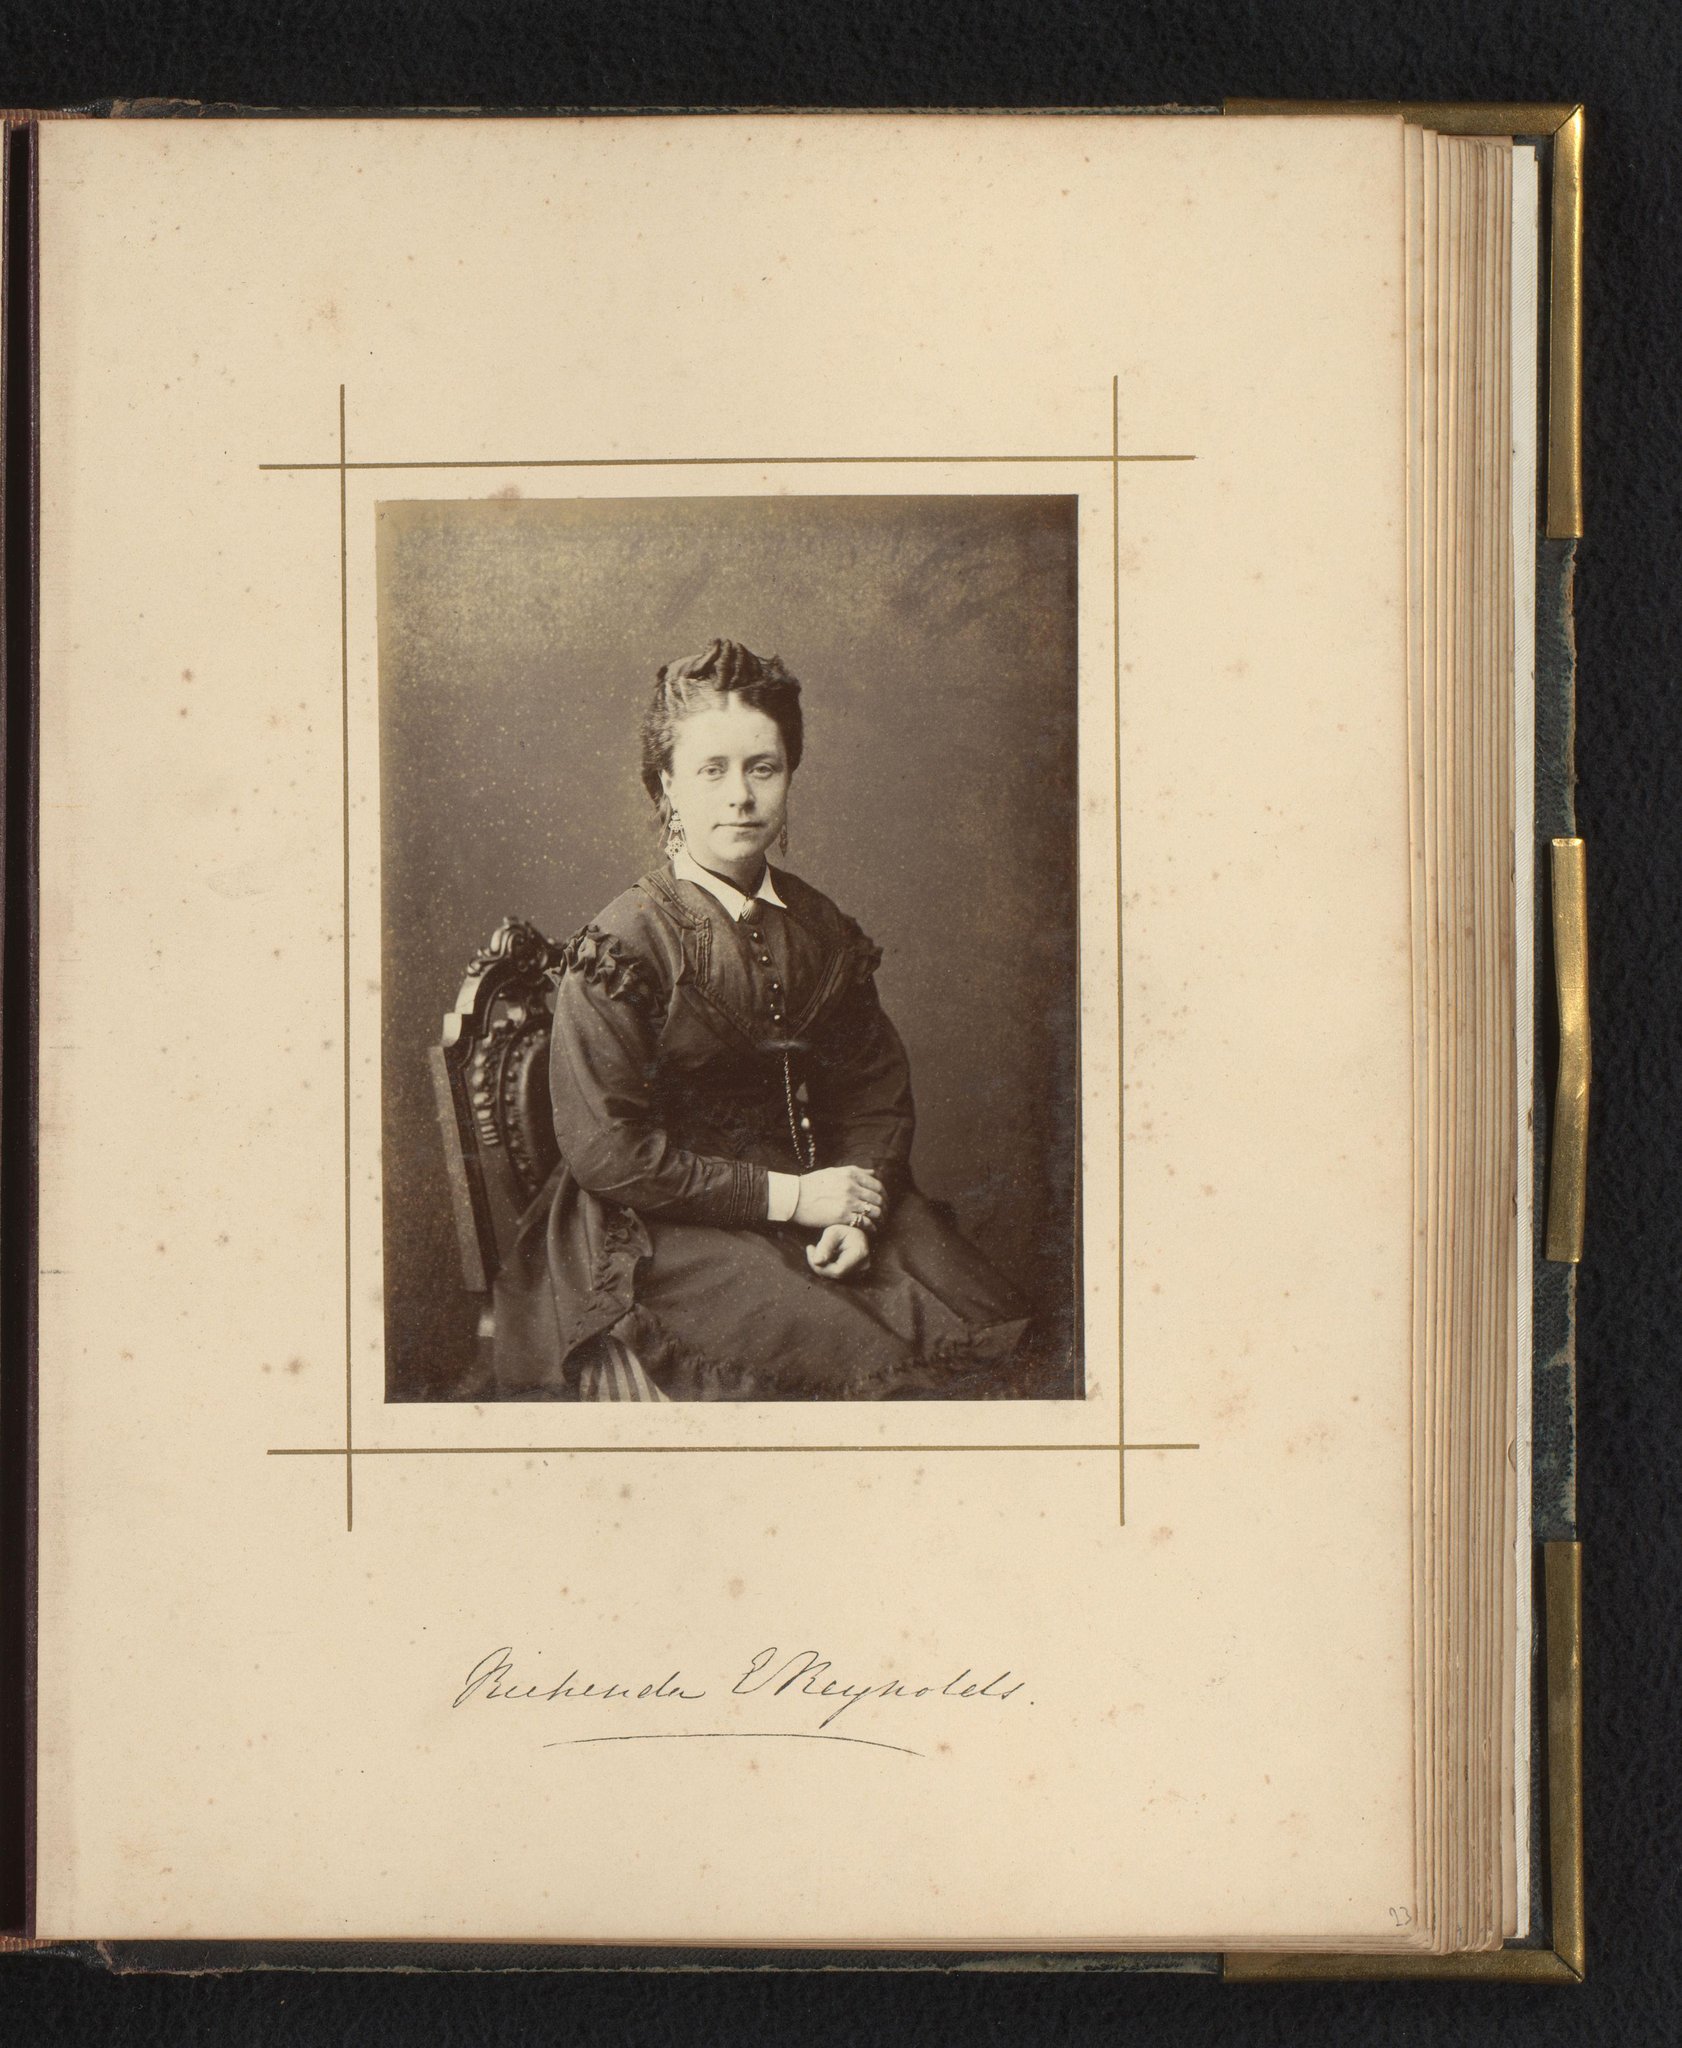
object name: photograph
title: Portret van een vrouw, mogelijk Behenda Reynolds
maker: Anonymous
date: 1866-1871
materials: photographic support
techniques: albumen print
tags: sitting figure - aa - female human figure, historical persons - bb - woman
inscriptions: name: ‘[Behenda] Reynolds’